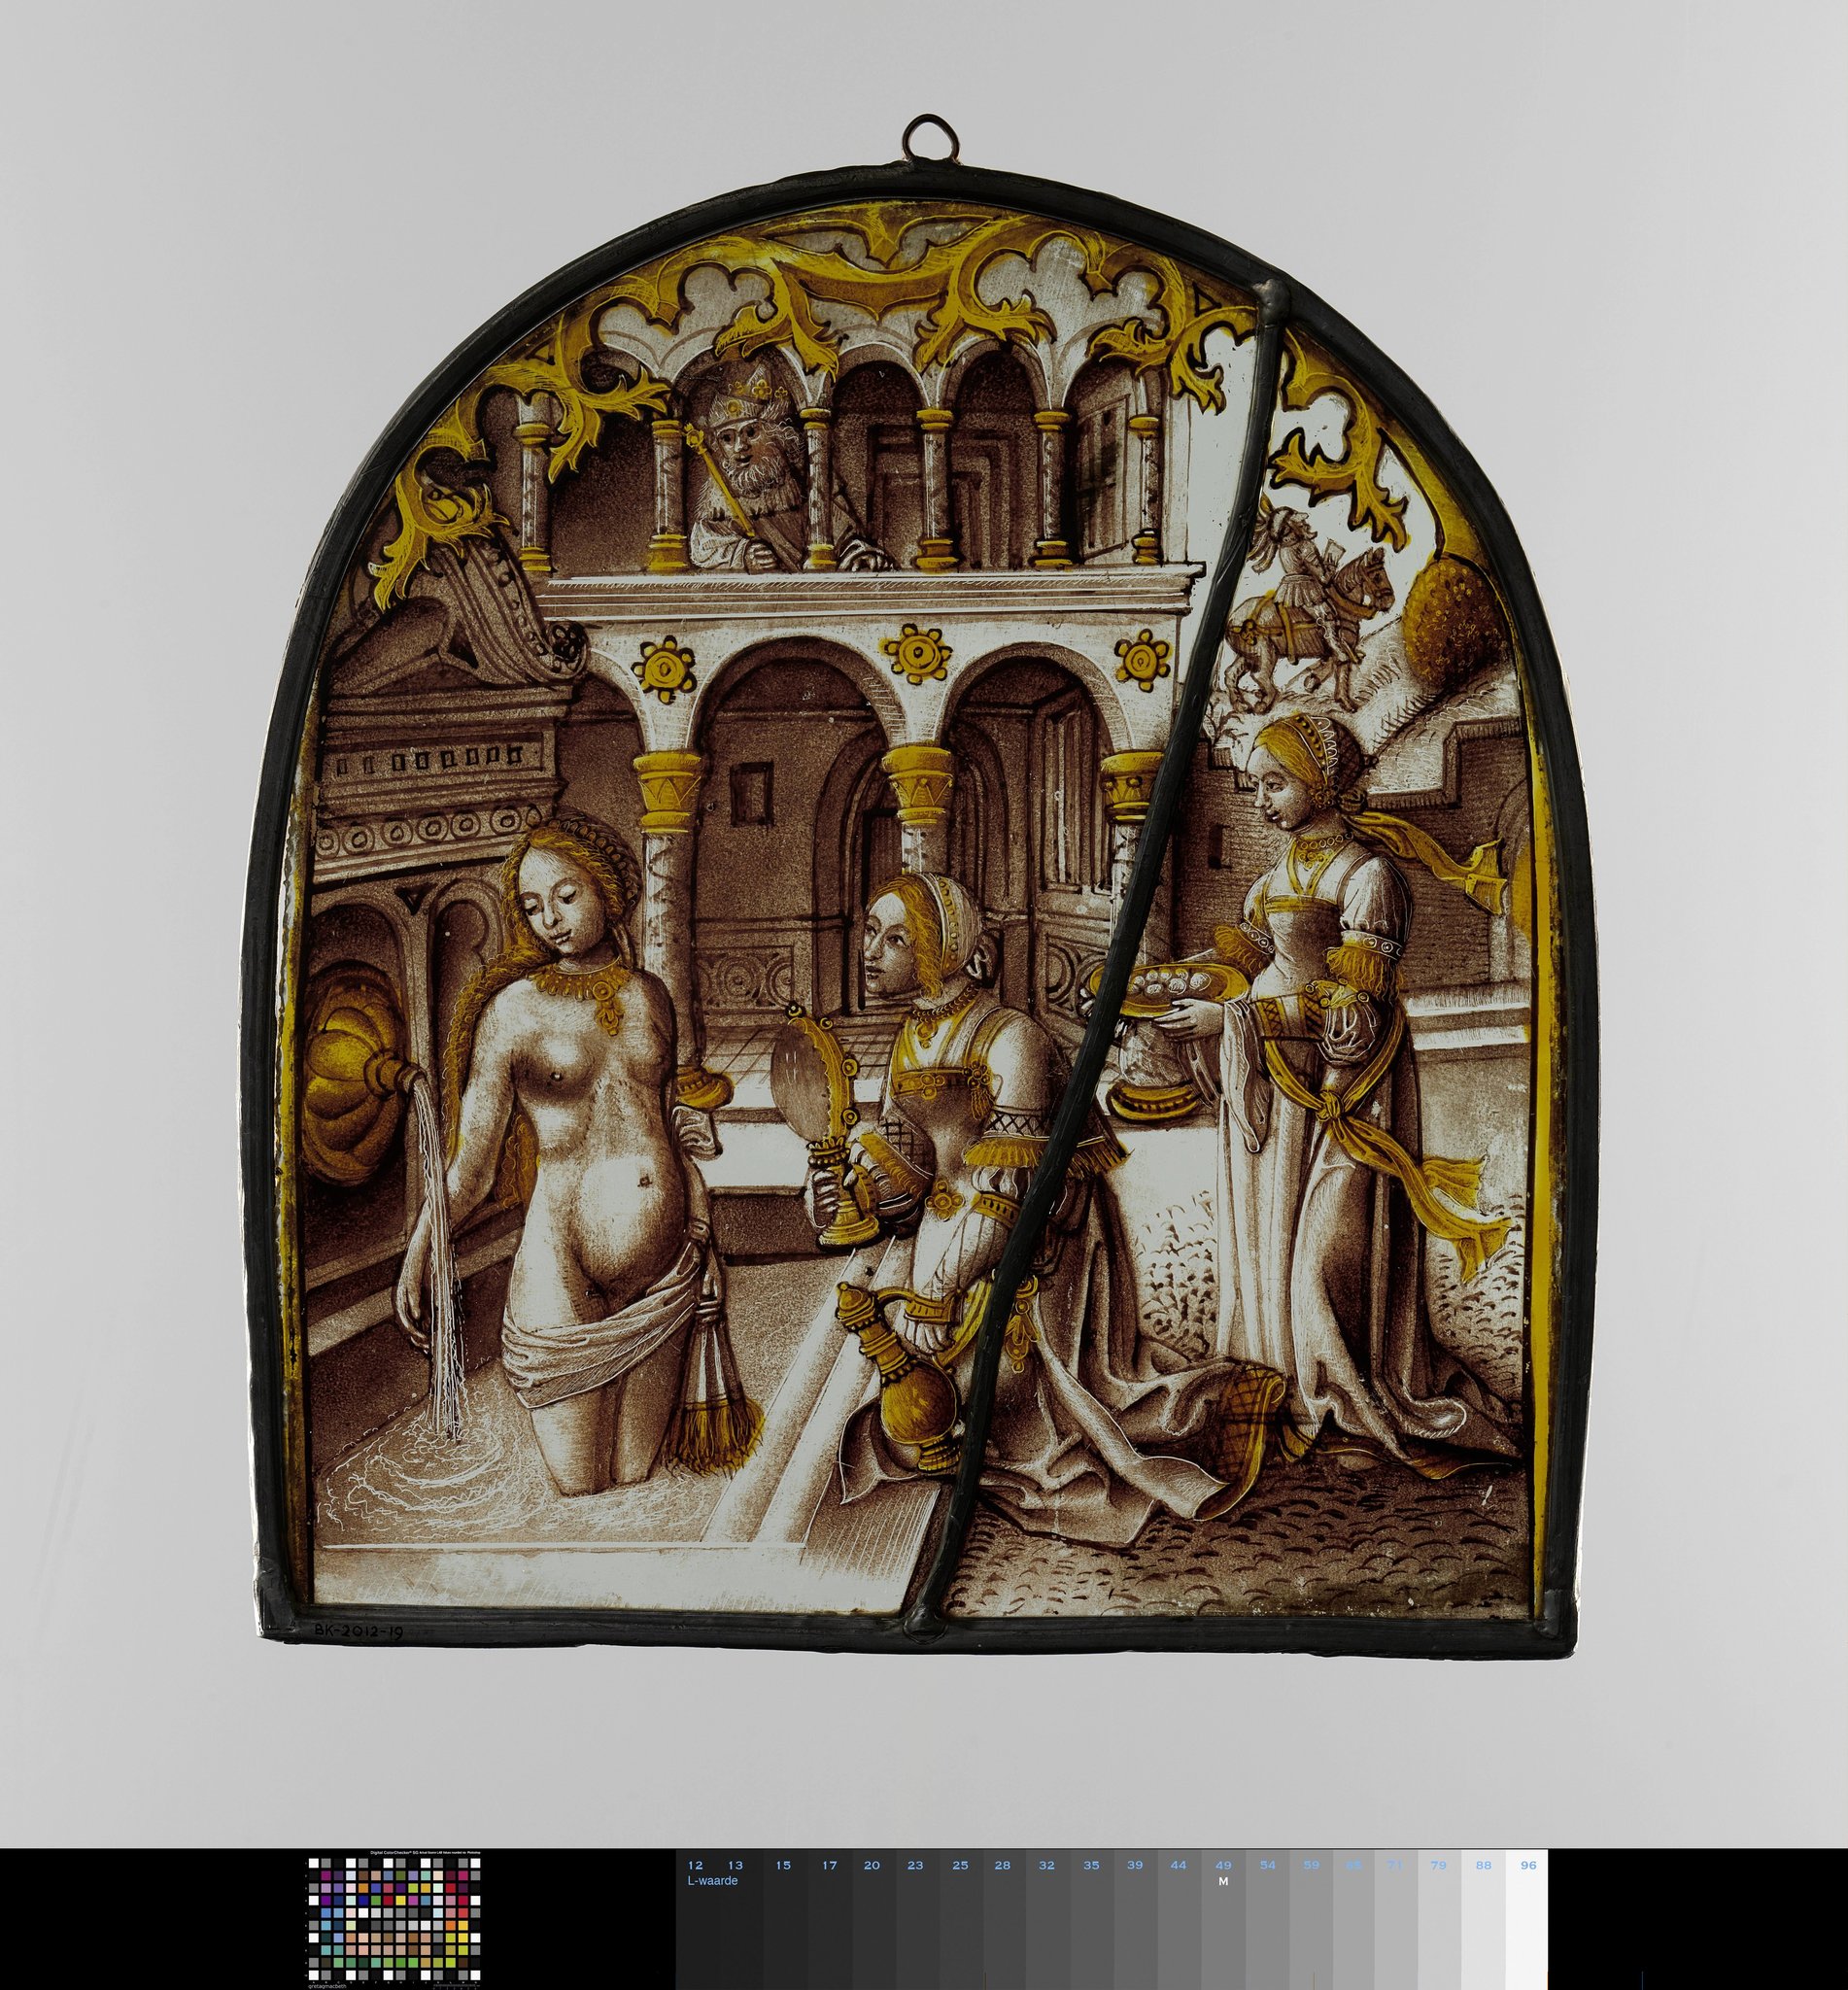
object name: stained glass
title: David en Bathseba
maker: Anonymous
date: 1520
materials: glass, lead, pigment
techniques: enamel painting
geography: low countries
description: David en Bathseba (2 Samuel 11:2). Ruit van gebrandschilderd glas in grisaille en zilvergeel, boogvormig. De scene wordt aan de gebogen bovenzijde afgesloten door een rand van Gotisch acanthuswerk, voortspruitend uit de rand van de voorstelling. De ruit behoort tot een reeks gewijd aan oudtestamentische scenes uit het leven van David.